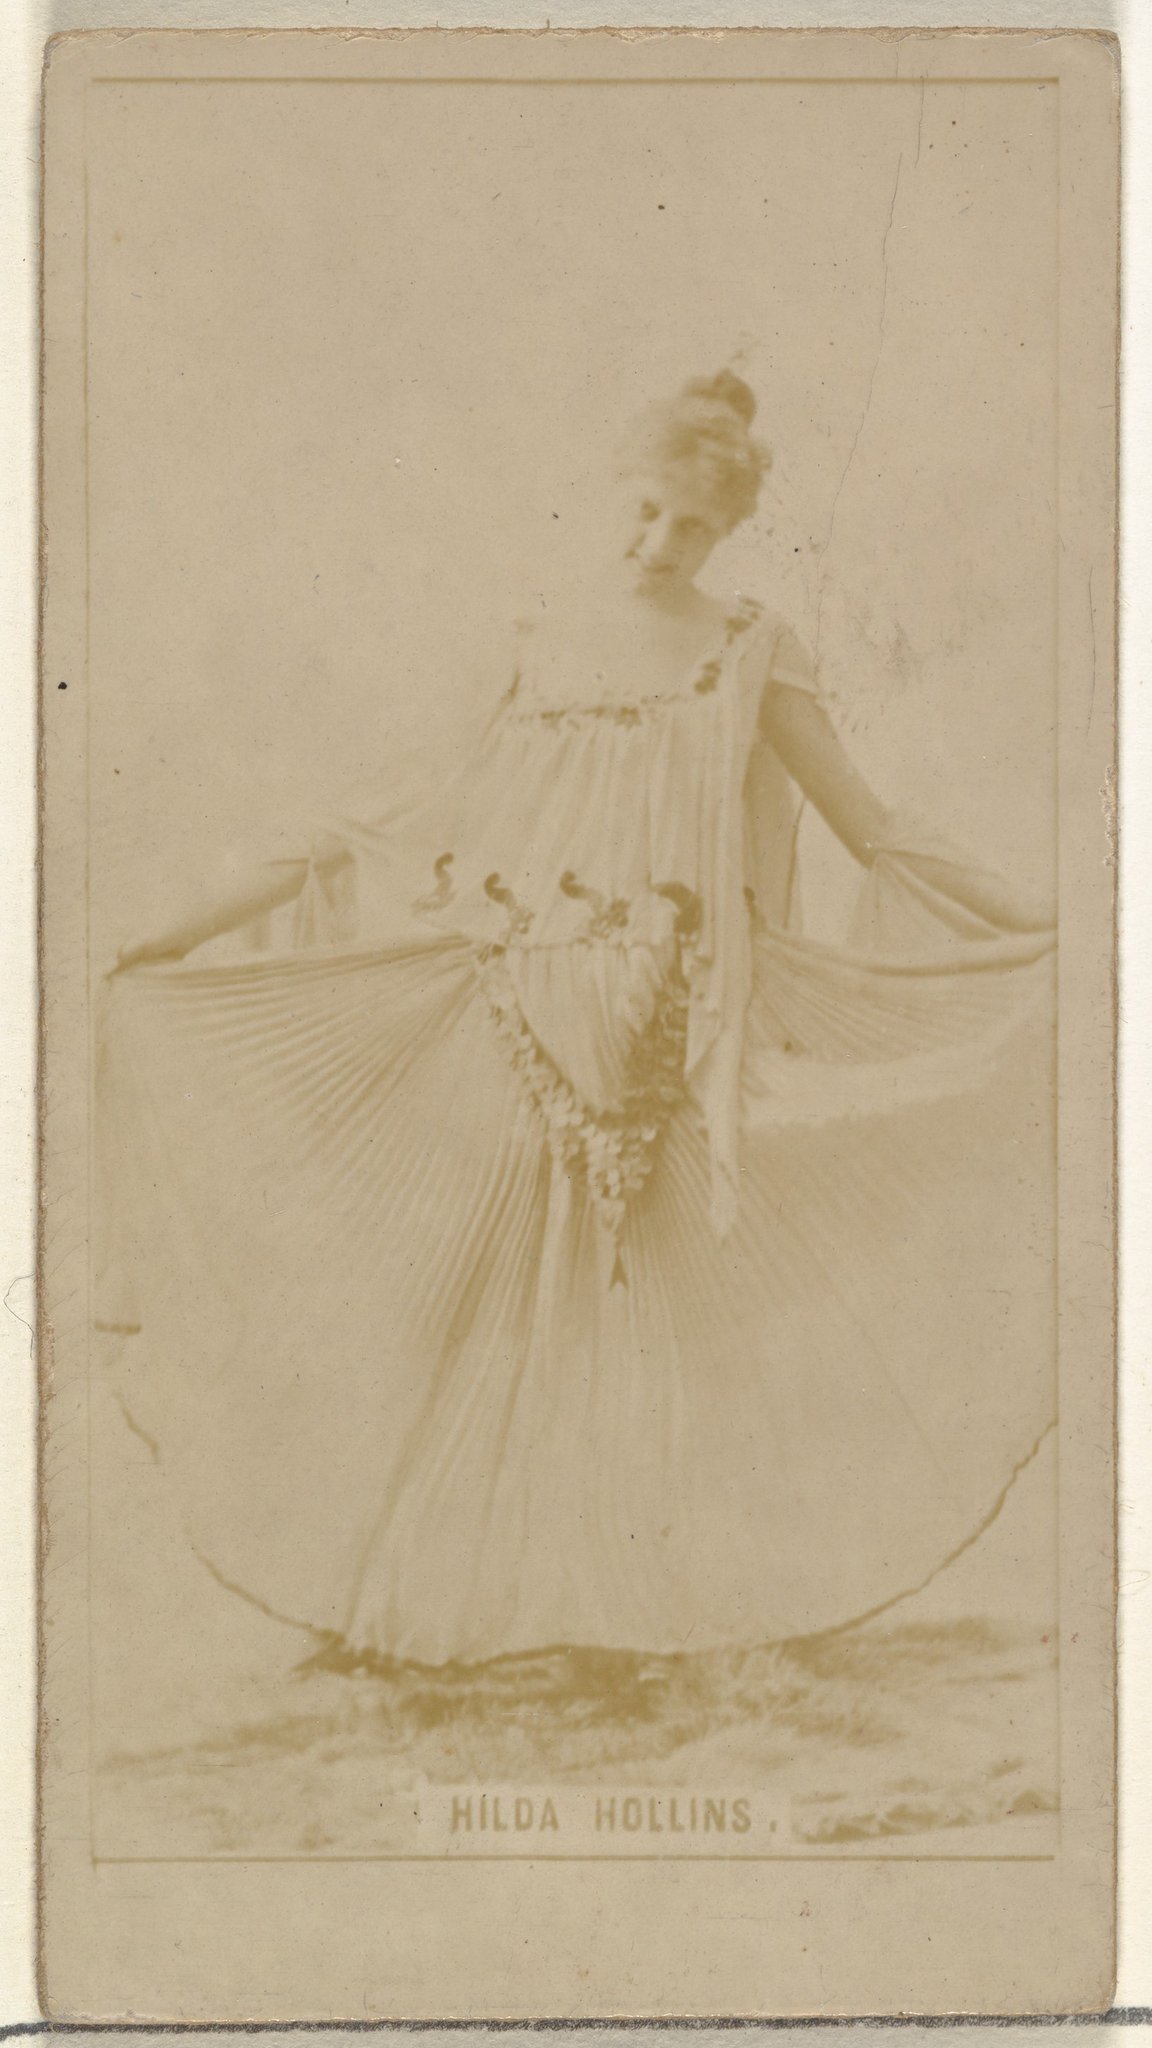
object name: photograph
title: Hilda Hollins, from the Actors and Actresses series (N145-8) issued by Duke Sons & Co. to promote Duke Cigarettes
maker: w. duke, sons & co.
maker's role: publisher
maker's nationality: american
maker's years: 1870-1920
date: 1891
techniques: albumen silver print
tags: portraits,women,actresses